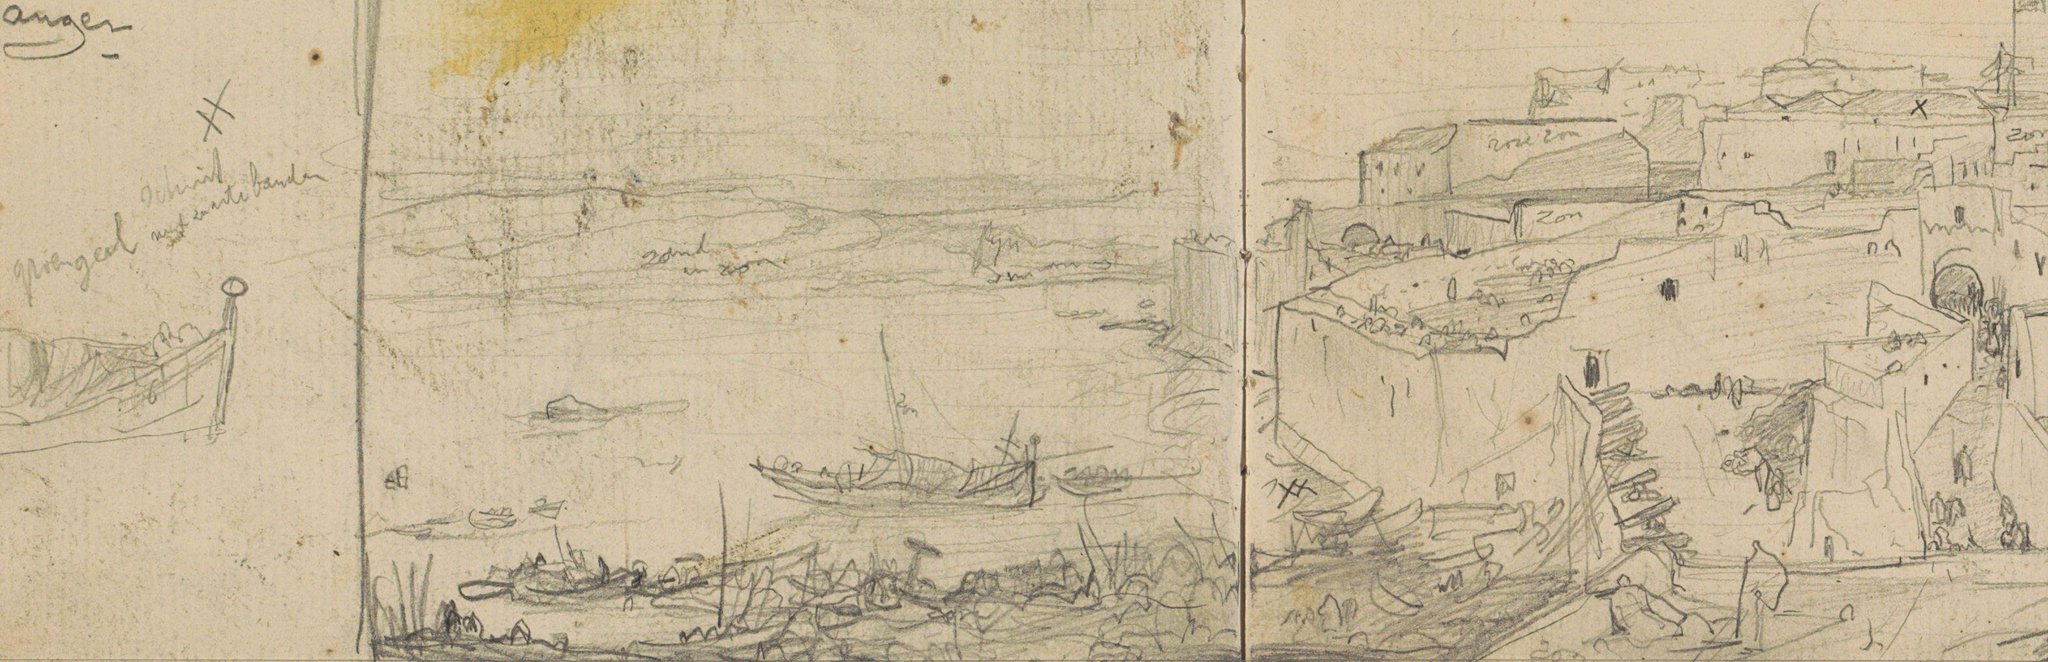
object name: sketchbook leaf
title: Gezicht op de haven van Tanger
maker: marius bauer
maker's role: draughtsman, print maker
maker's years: 1867-1932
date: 1902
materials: paper, pencil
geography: tanger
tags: harbour, city-view, and landscape with man-made constructions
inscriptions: annotation: ‘Tanger’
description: Pagina 18 en 19 uit een schetsboek met 30 bladen.